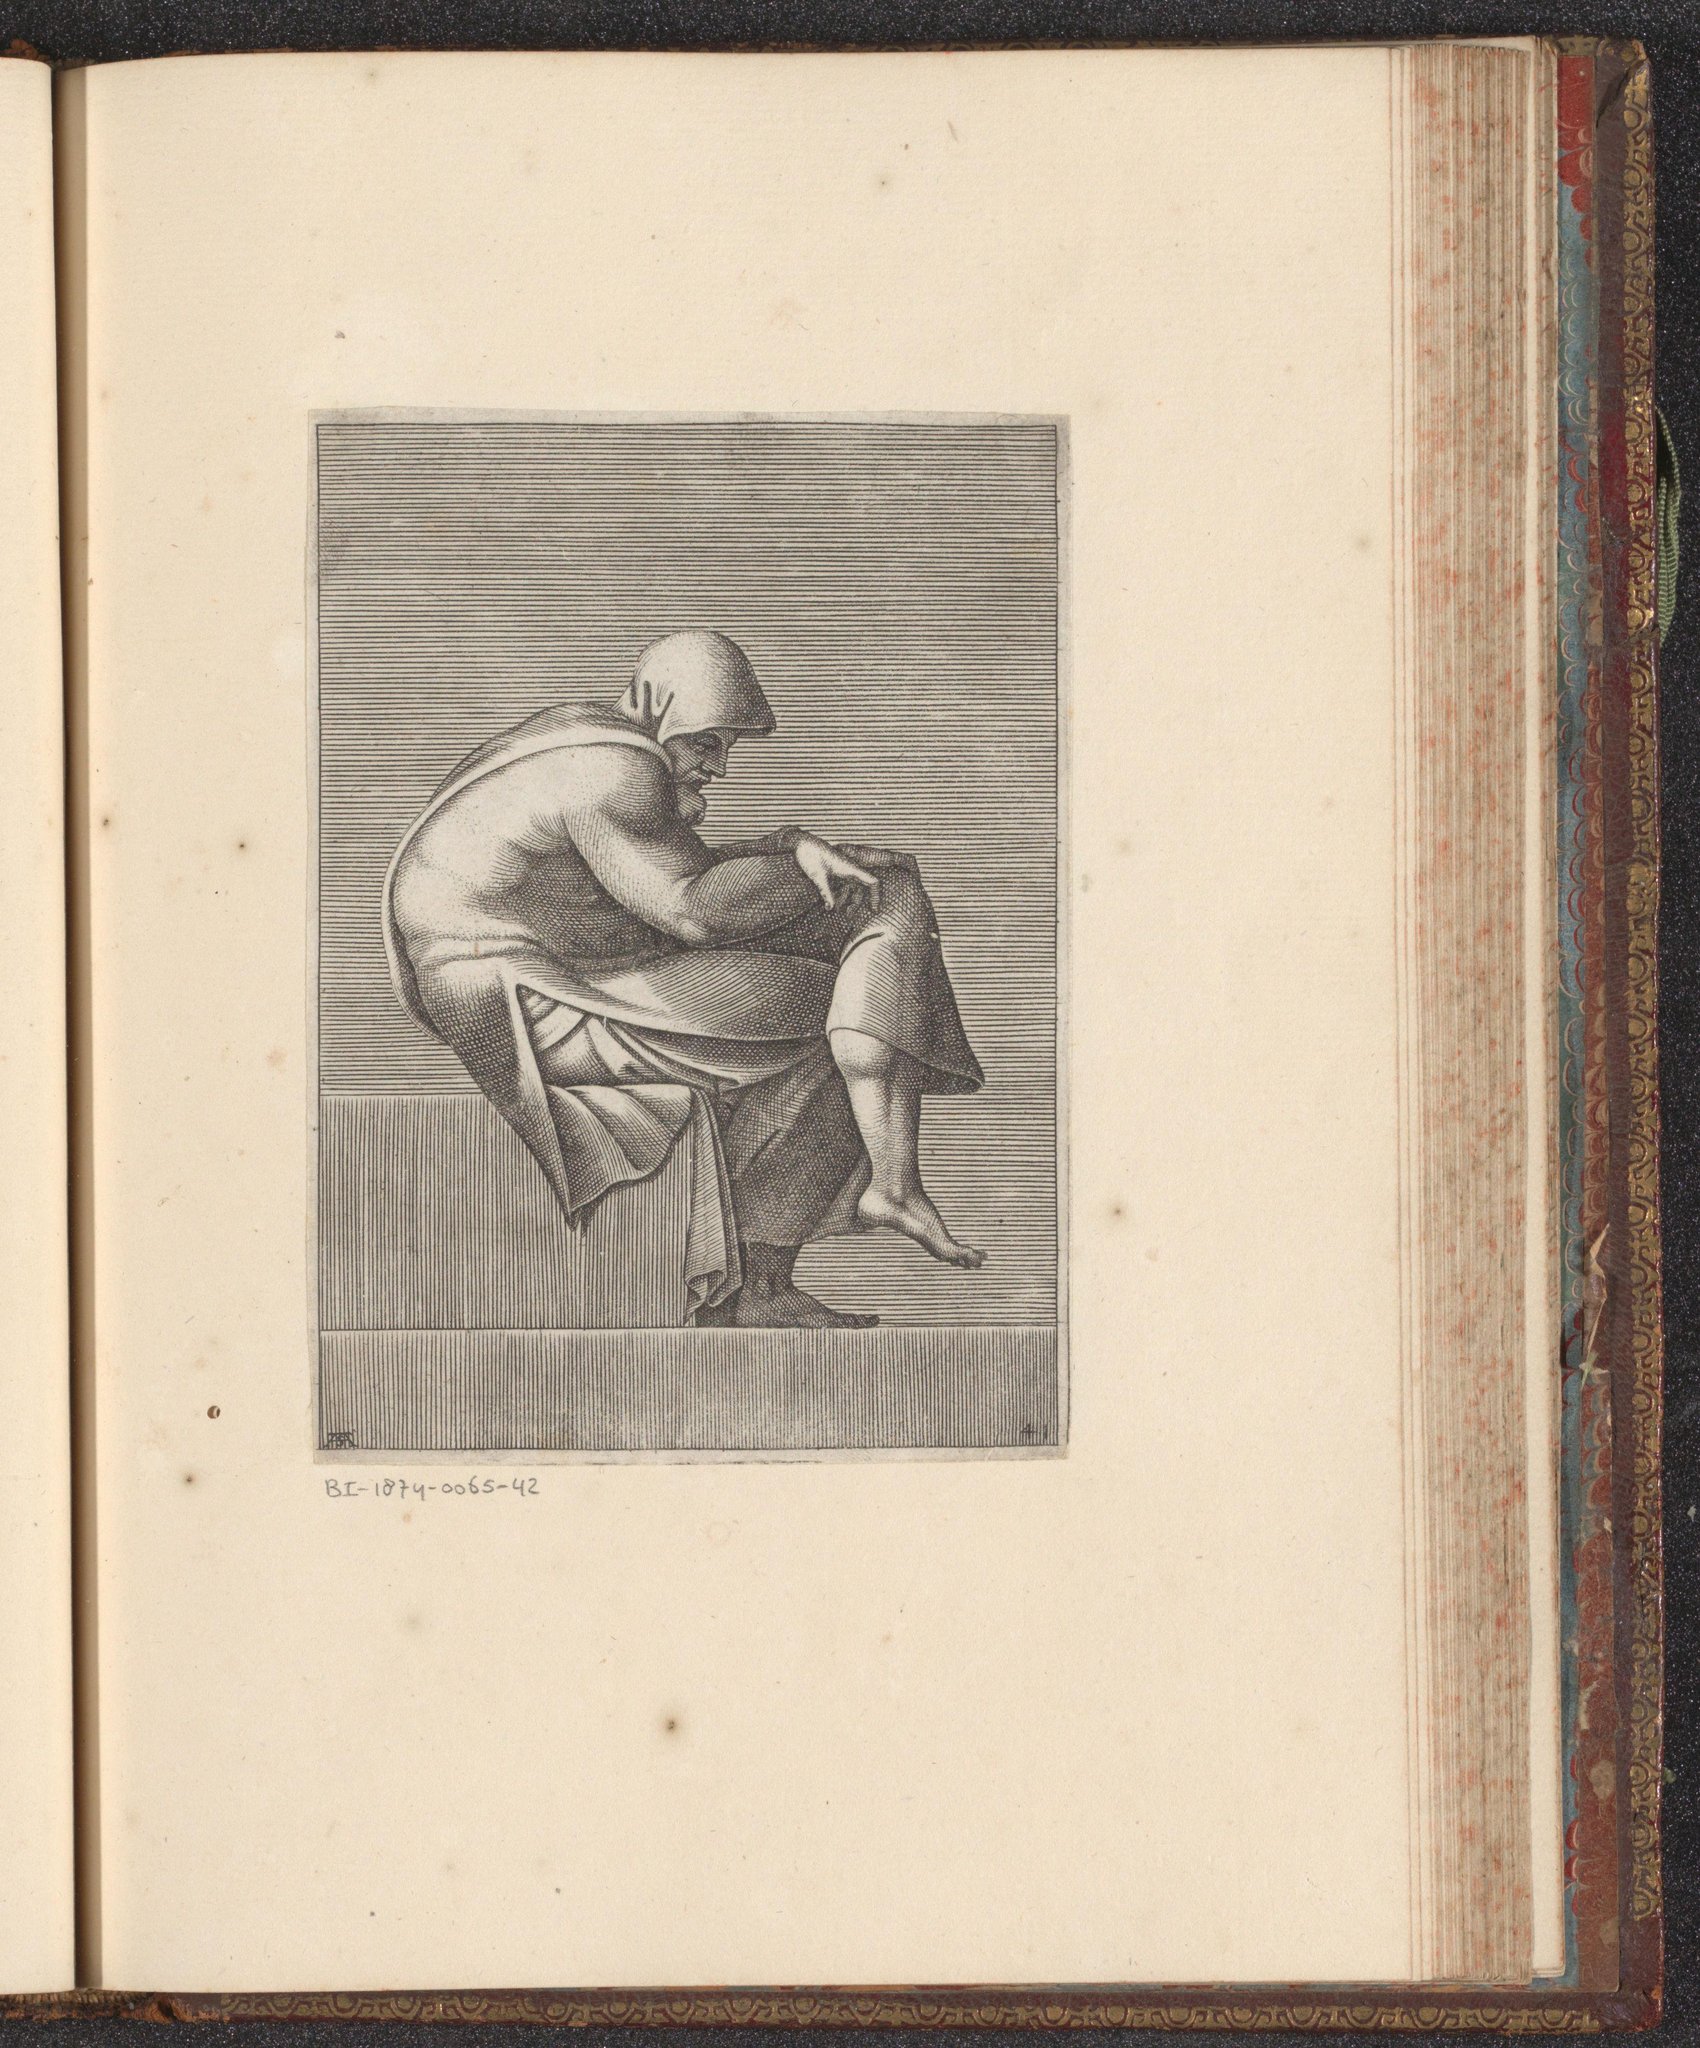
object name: print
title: Schilderingen in de Sixtijnse kapel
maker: adamo scultori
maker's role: painter, print maker, sculptor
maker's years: 1530-1585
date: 1585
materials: paper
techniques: engraving, intaglio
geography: vatican city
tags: the (nude) human figure; 'corpo humano' (ripa), fruits: acorn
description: Deze prent maakt deel uit van een serie bestaande uit een titelprent en 72 prenten naar schilderingen door Michelangelo in de Sixtijnse Kapel in het Vaticaan.